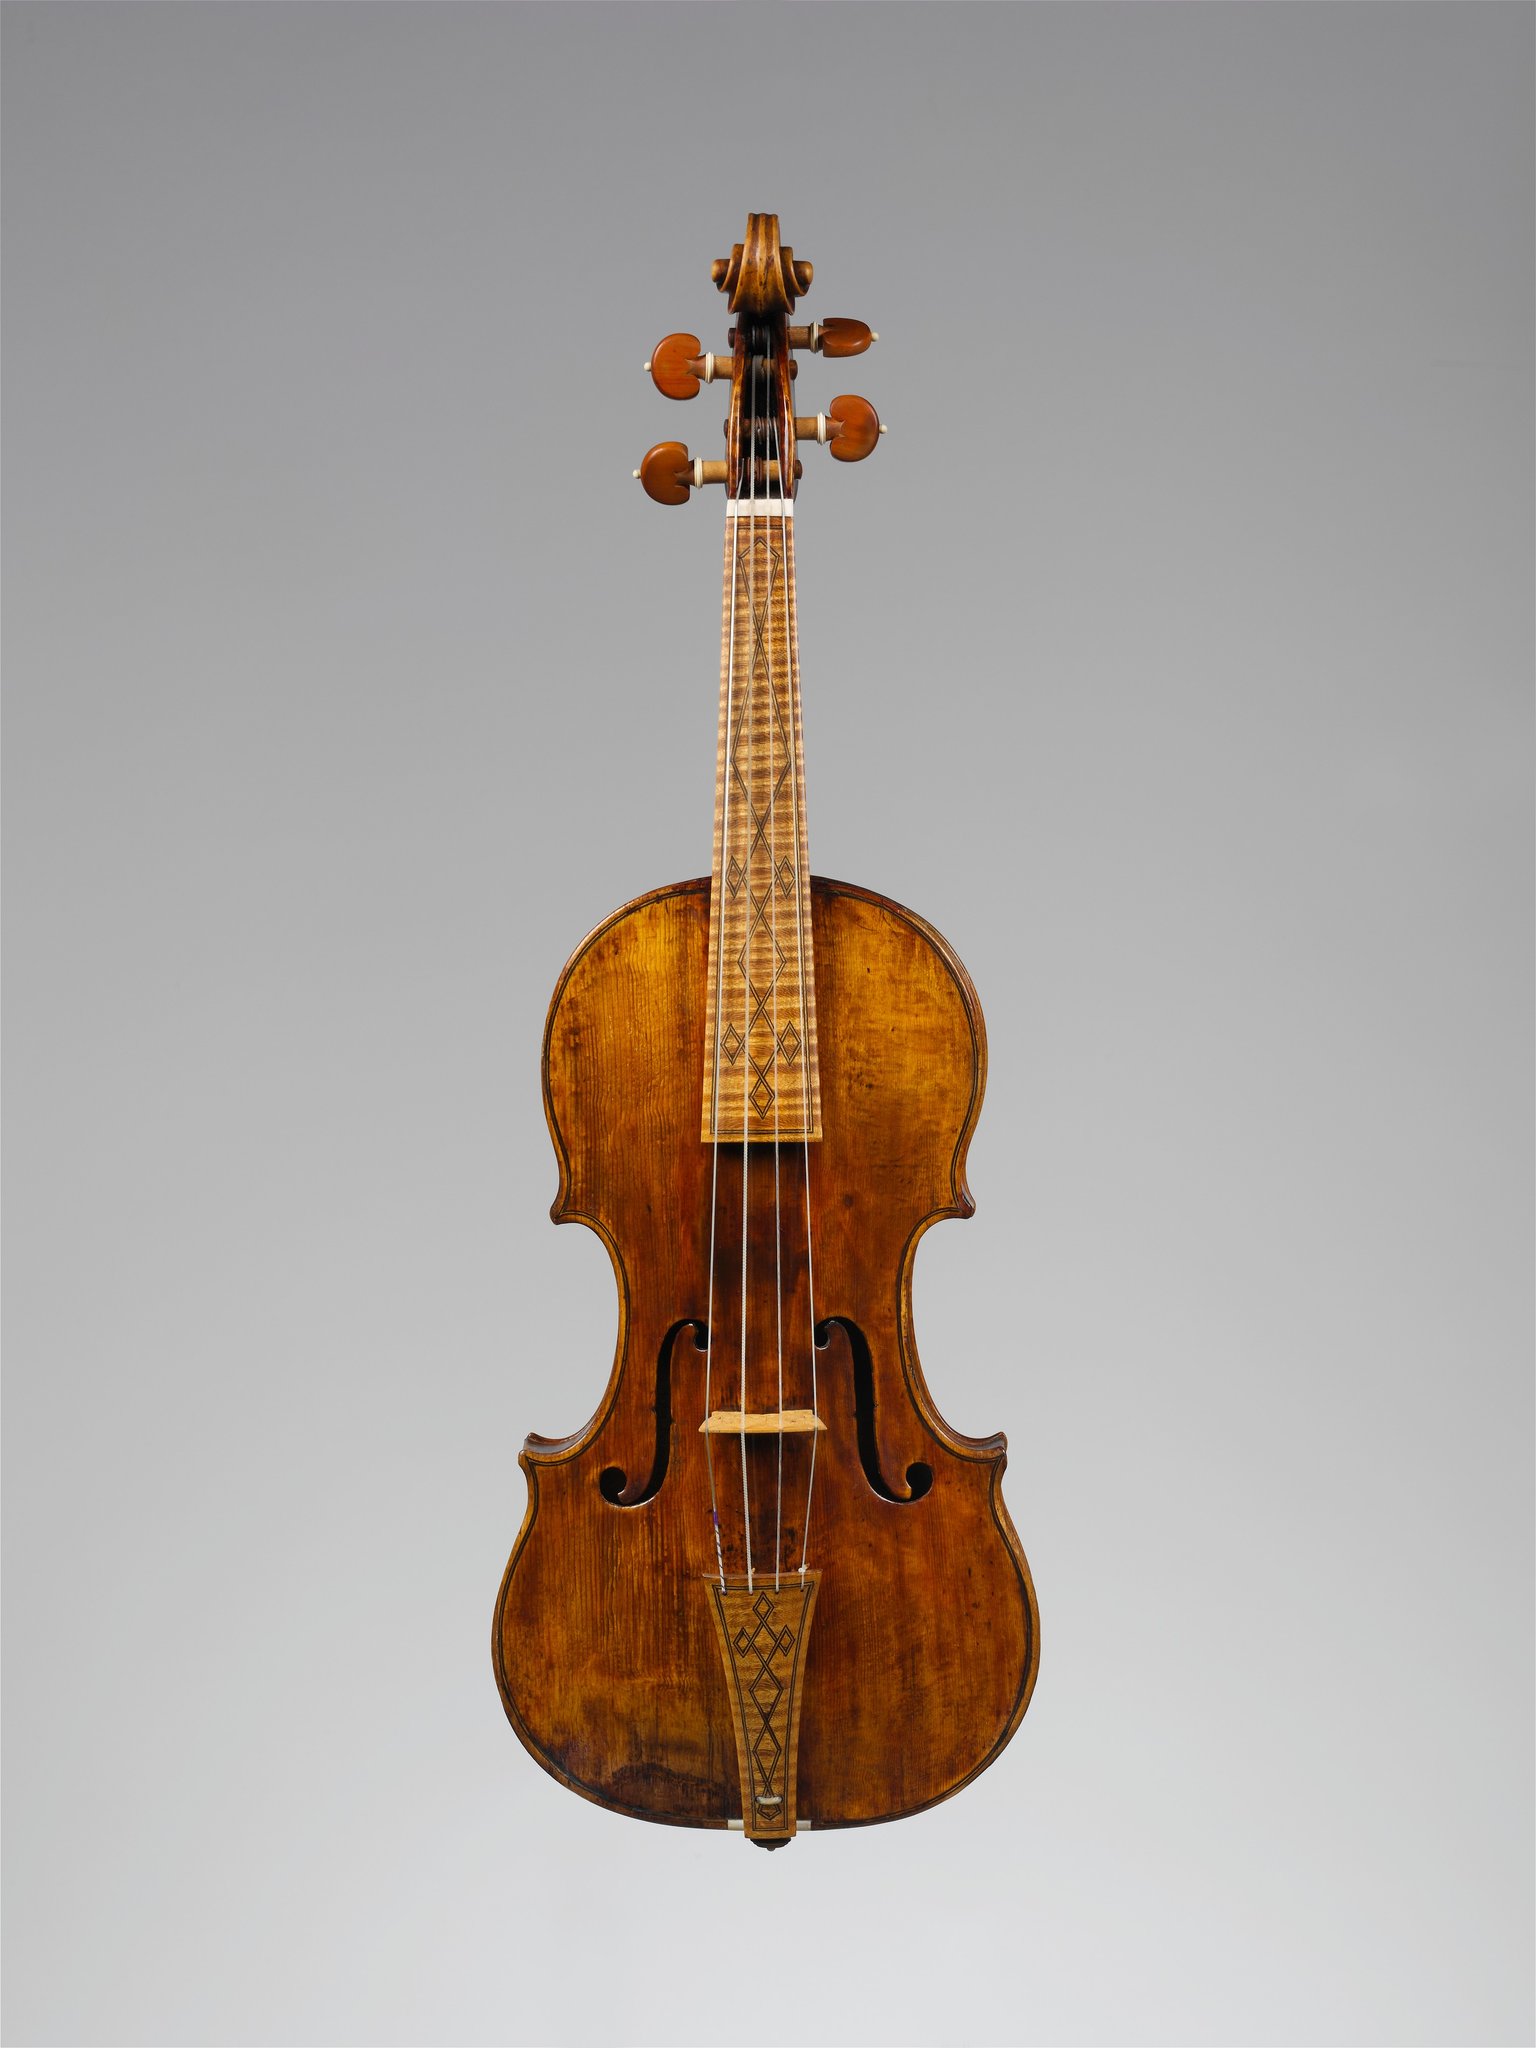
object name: violin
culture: italian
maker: nicolò amati (cremona 1596–1684 cremona)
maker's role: maker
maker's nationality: italian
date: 1669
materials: wood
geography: italy